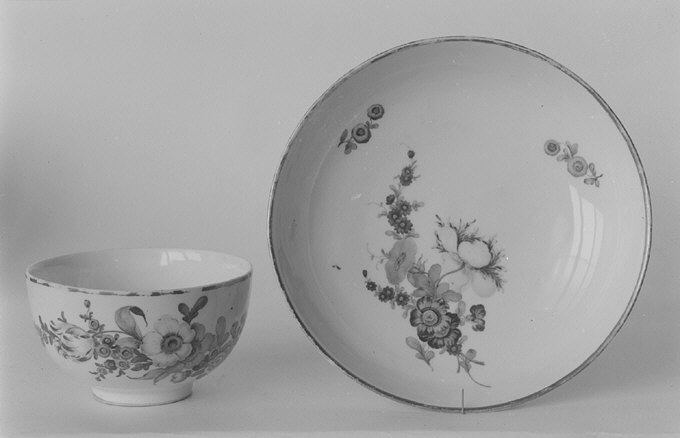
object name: teabowl and saucer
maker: zurich pottery and porcelain factory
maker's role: factory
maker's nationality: swiss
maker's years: 1763-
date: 1775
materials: hard paste porcelain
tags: flowers